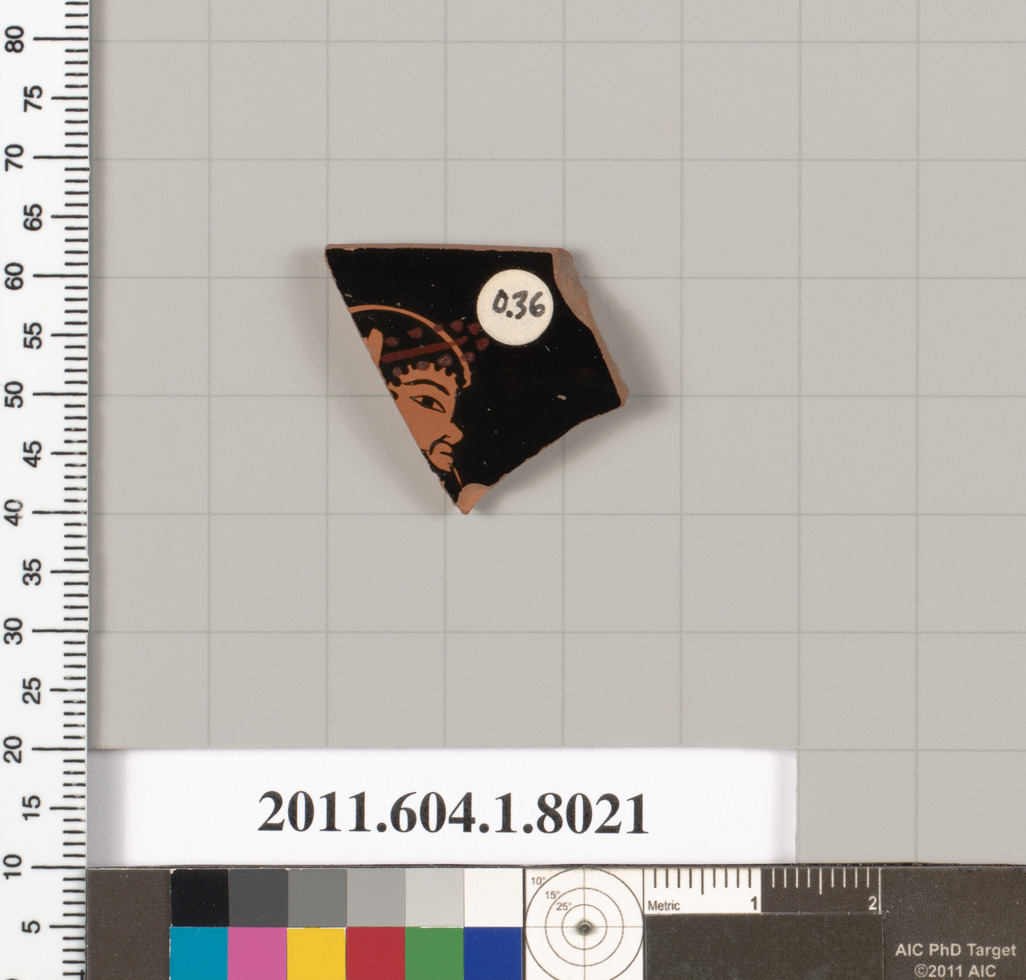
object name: kylix fragment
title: Terracotta rim fragment of a kylix (drinking cup)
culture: greek, attic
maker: euergides painter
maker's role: artist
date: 510-500 BCE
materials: terracotta